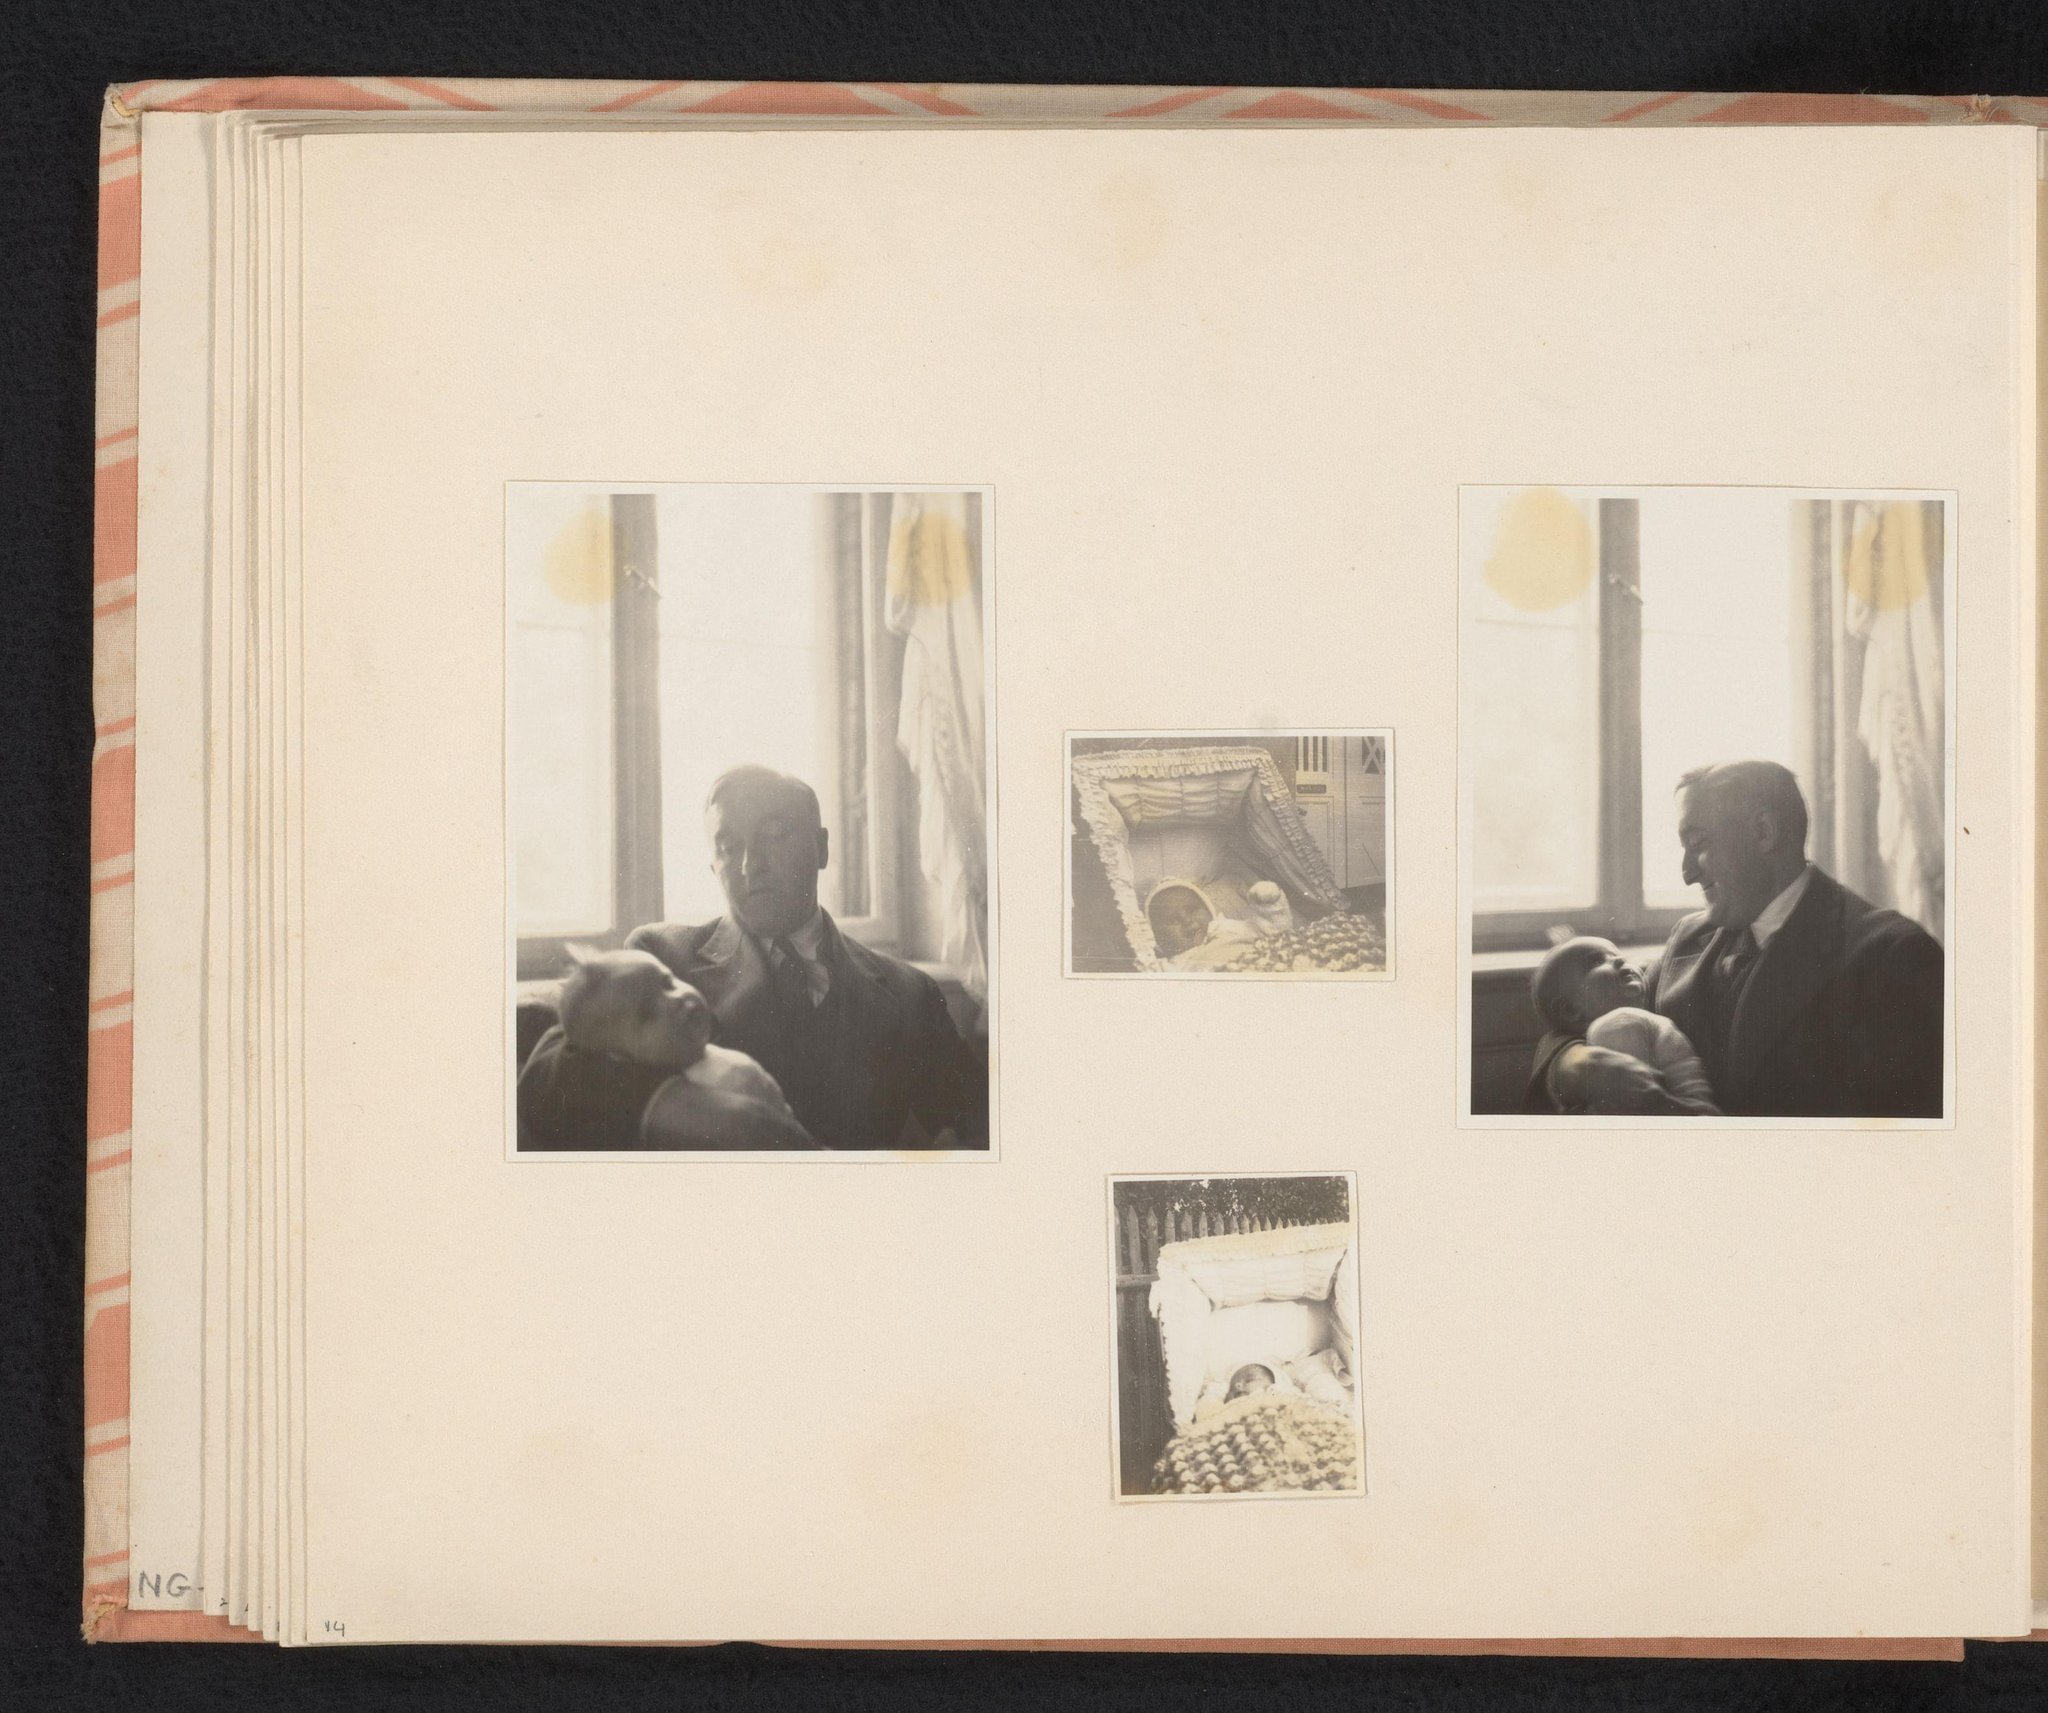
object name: album leaf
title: Isabel Wachenheimer in een kinderwagen, en in de armen van haar vader Eugen Wachenheimer, 30 december 1928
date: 1928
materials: paper, photographic support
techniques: gelatin silver print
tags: eugen wachenheimer, isabel wachenheimer-elon, family life at home, infant, baby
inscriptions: date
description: Albumblad met vier foto's. Foto's links en rechts, Isabel Wachenheimer (links) en Eugen Wachenheimer (rechts); foto's midden, Isabel Wachenheimer. Onderdeel van het fotoalbum met foto's van Isabel Wachenheimer als kind (1928-1931).